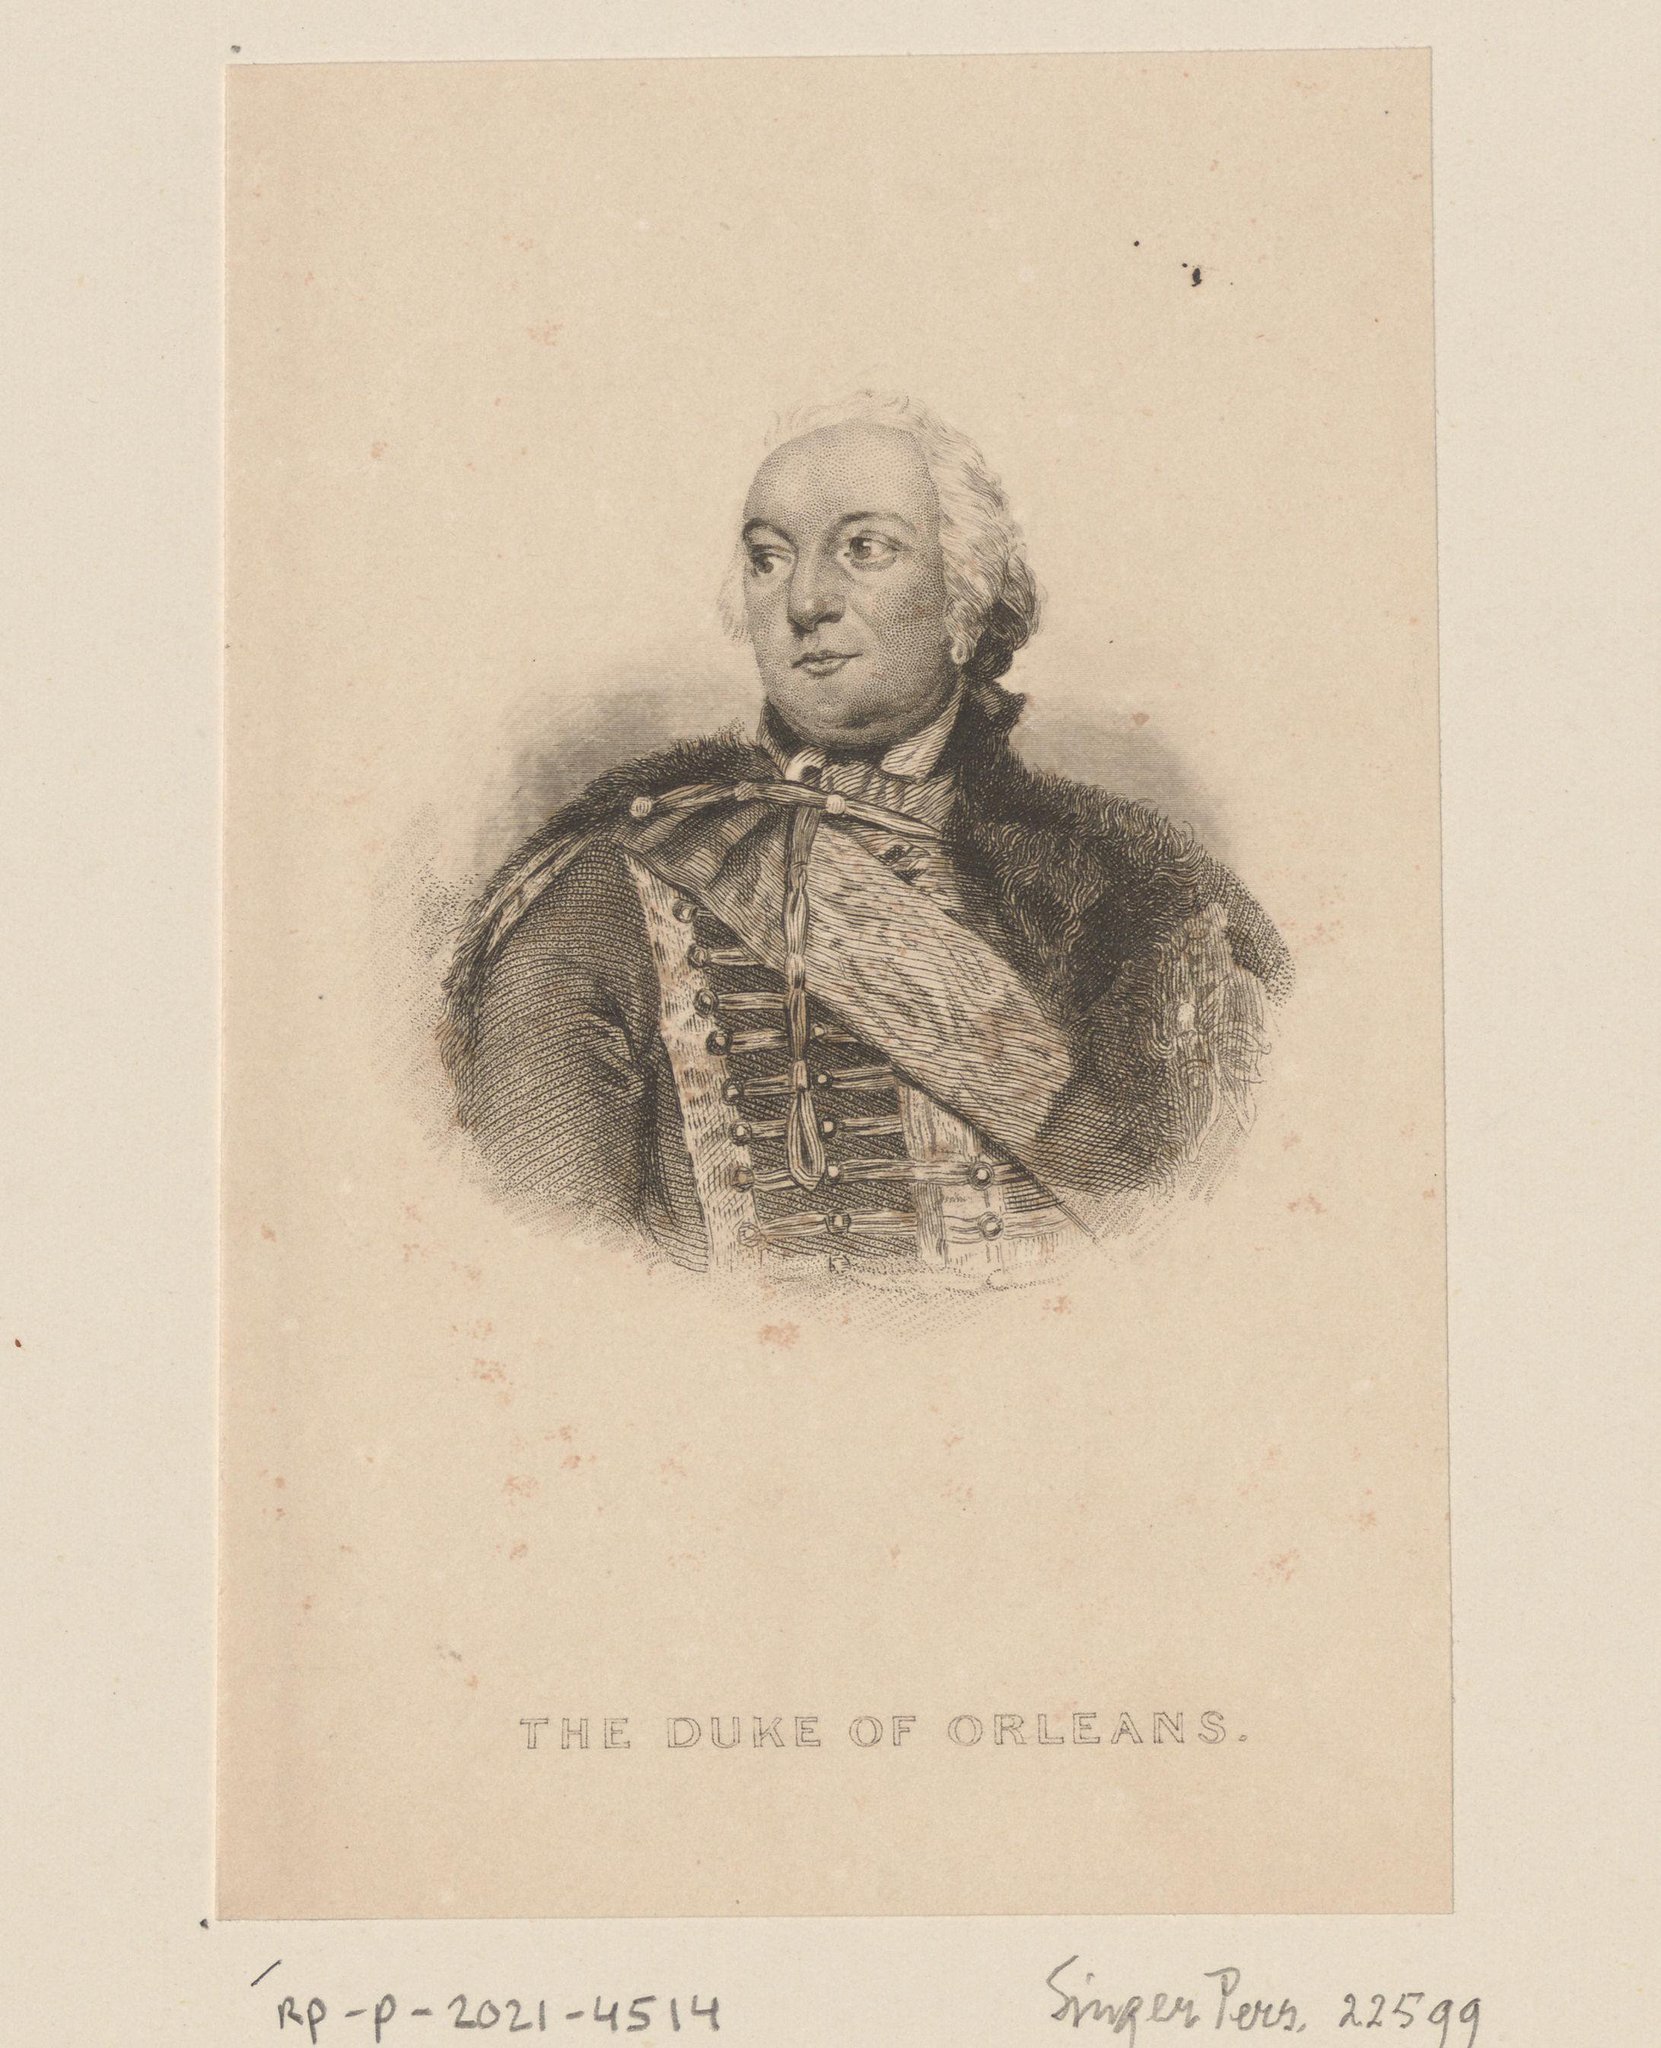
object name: print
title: Portret van Lodewijk Filips II van Orléans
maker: Anonymous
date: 1785-1850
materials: paper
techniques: engraving, etching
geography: england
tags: paris, lodewijk filips ii (hertog van orléans), historical persons